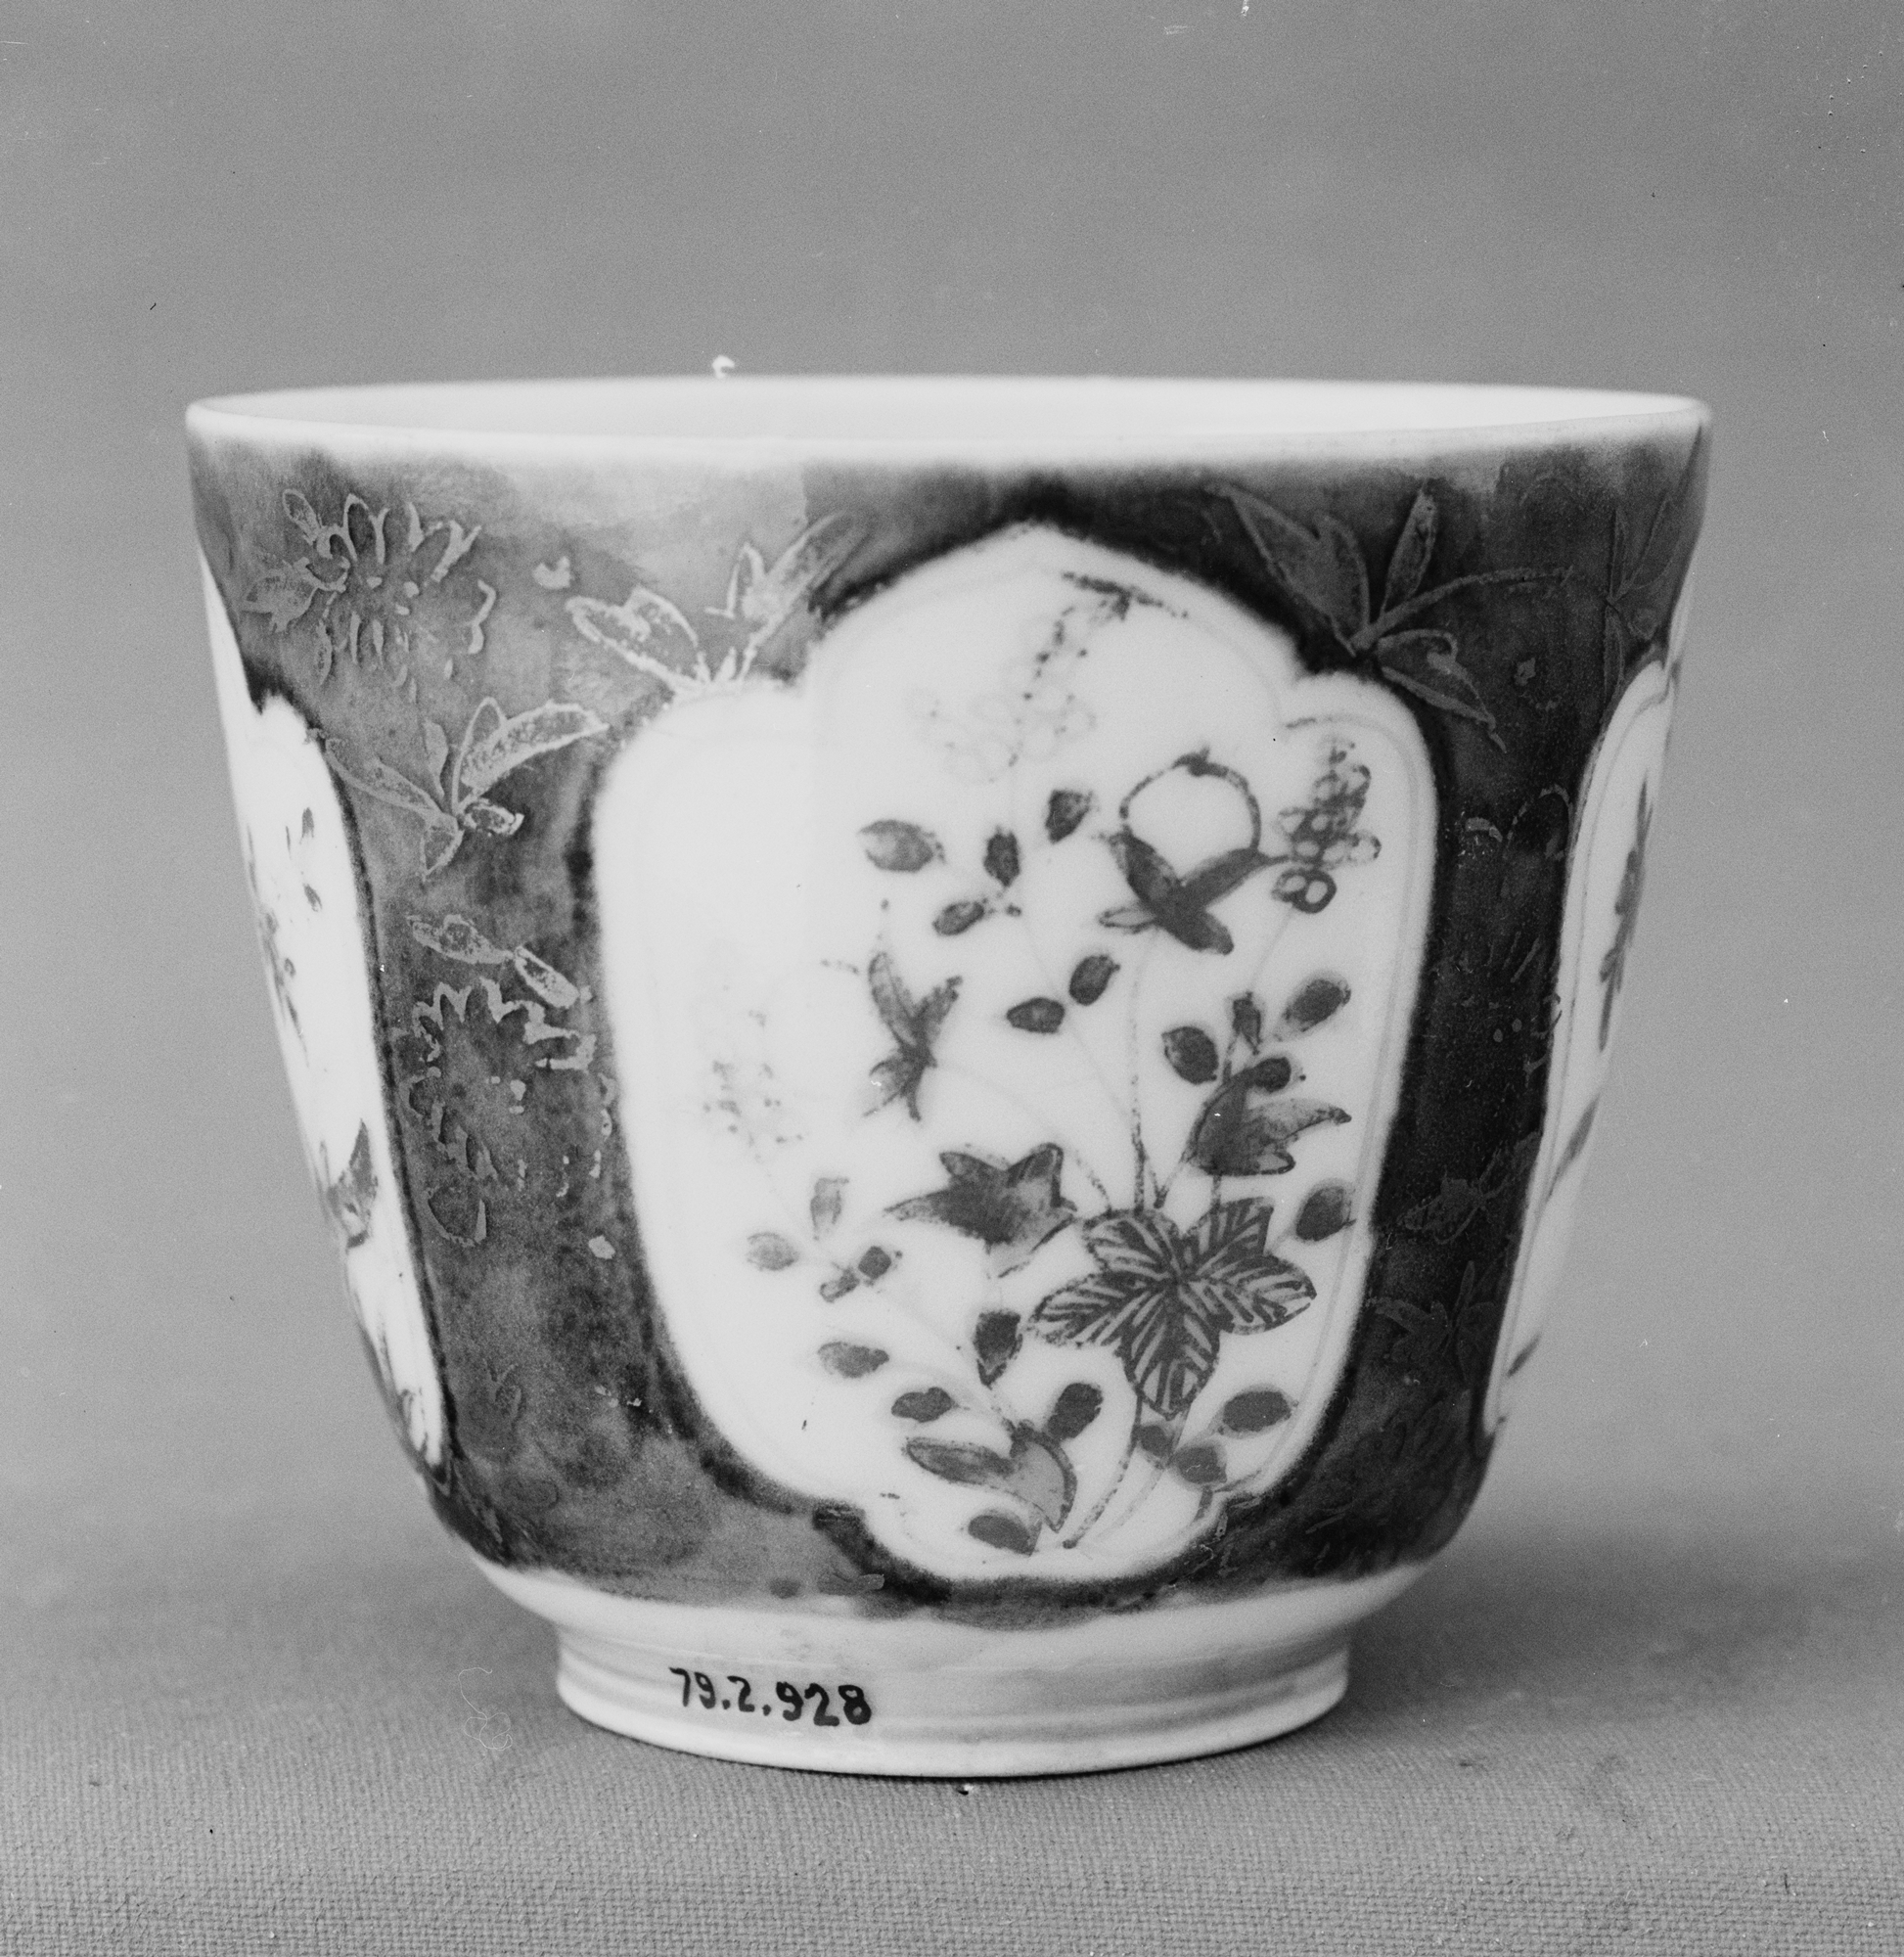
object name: cup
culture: japanese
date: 1701-1800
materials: glaze, gold, porcelain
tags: leaves